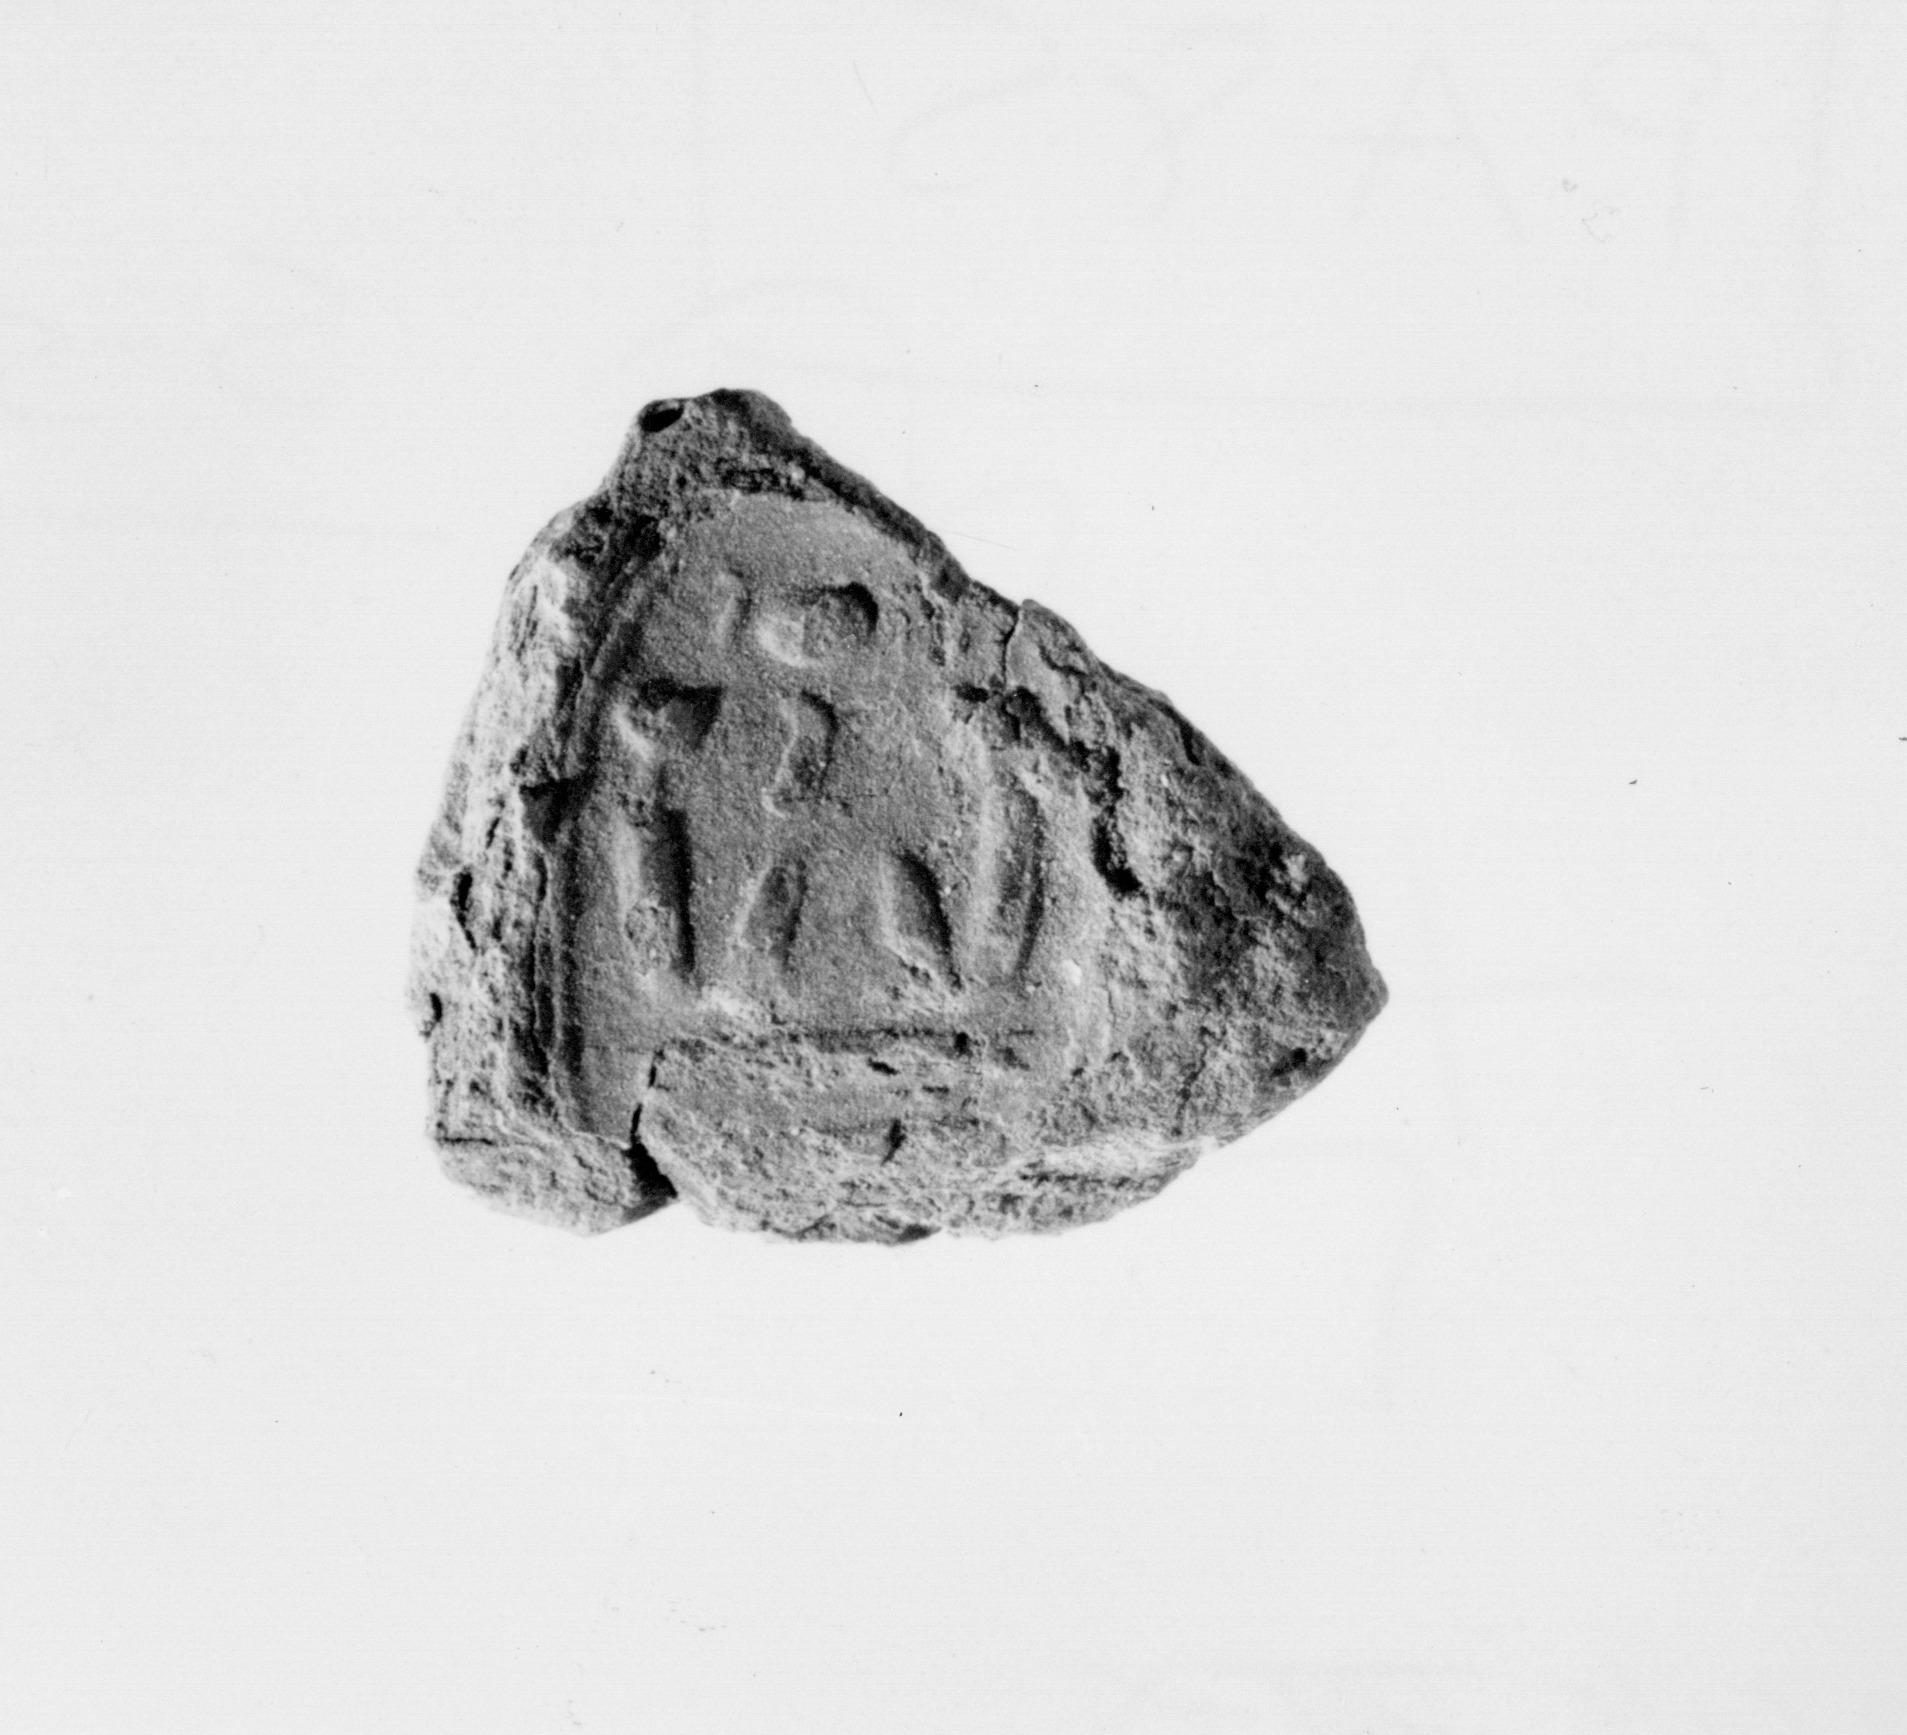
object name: sealing, nebmaatre, amenhotep iii, ptah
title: Document Sealing With the Throne Name of Amenhotep III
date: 1390-1352 BCE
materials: mud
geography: egypt